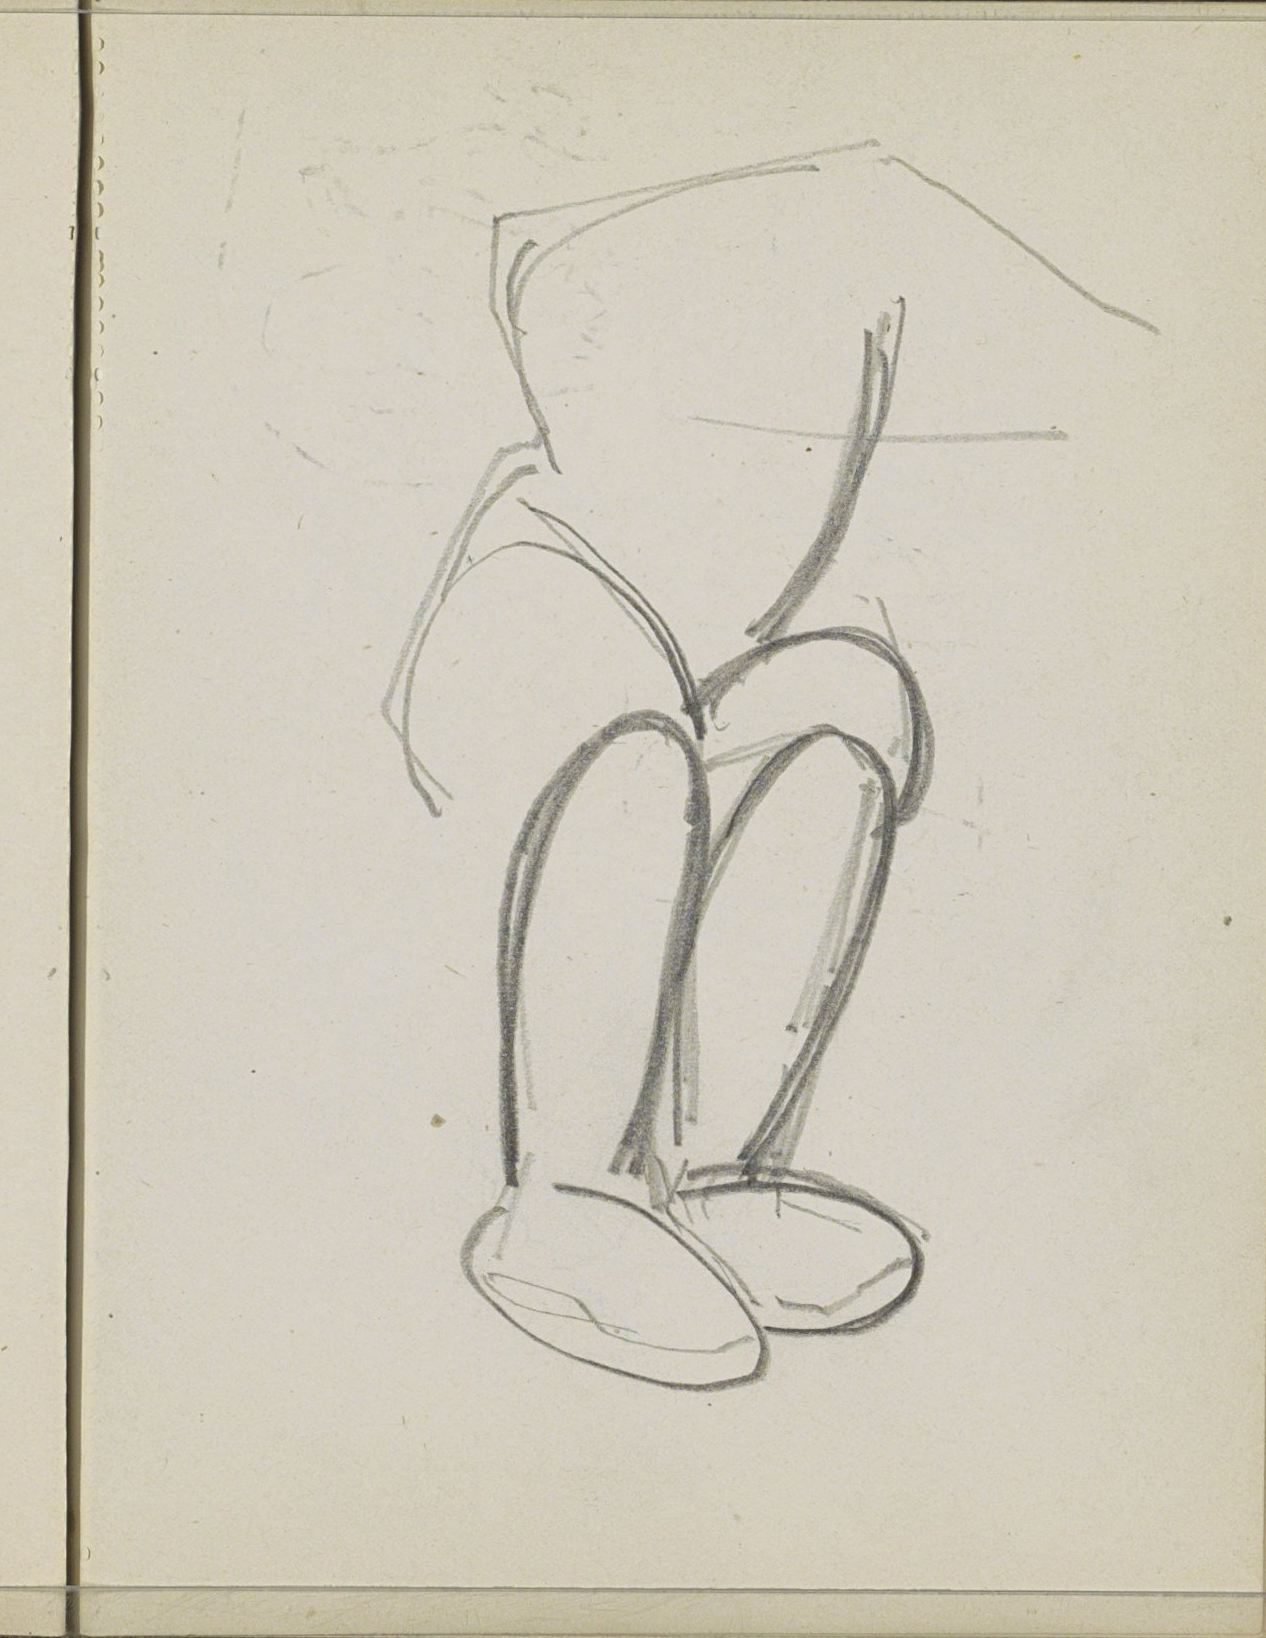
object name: sketchbook leaf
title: Figuur in een zithouding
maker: reijer stolk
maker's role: draughtsman, print maker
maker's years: 1896-1945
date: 1906-1945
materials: paper, pencil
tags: sitting figure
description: Blad 44 recto uit een schetsboek met 53 bladen.